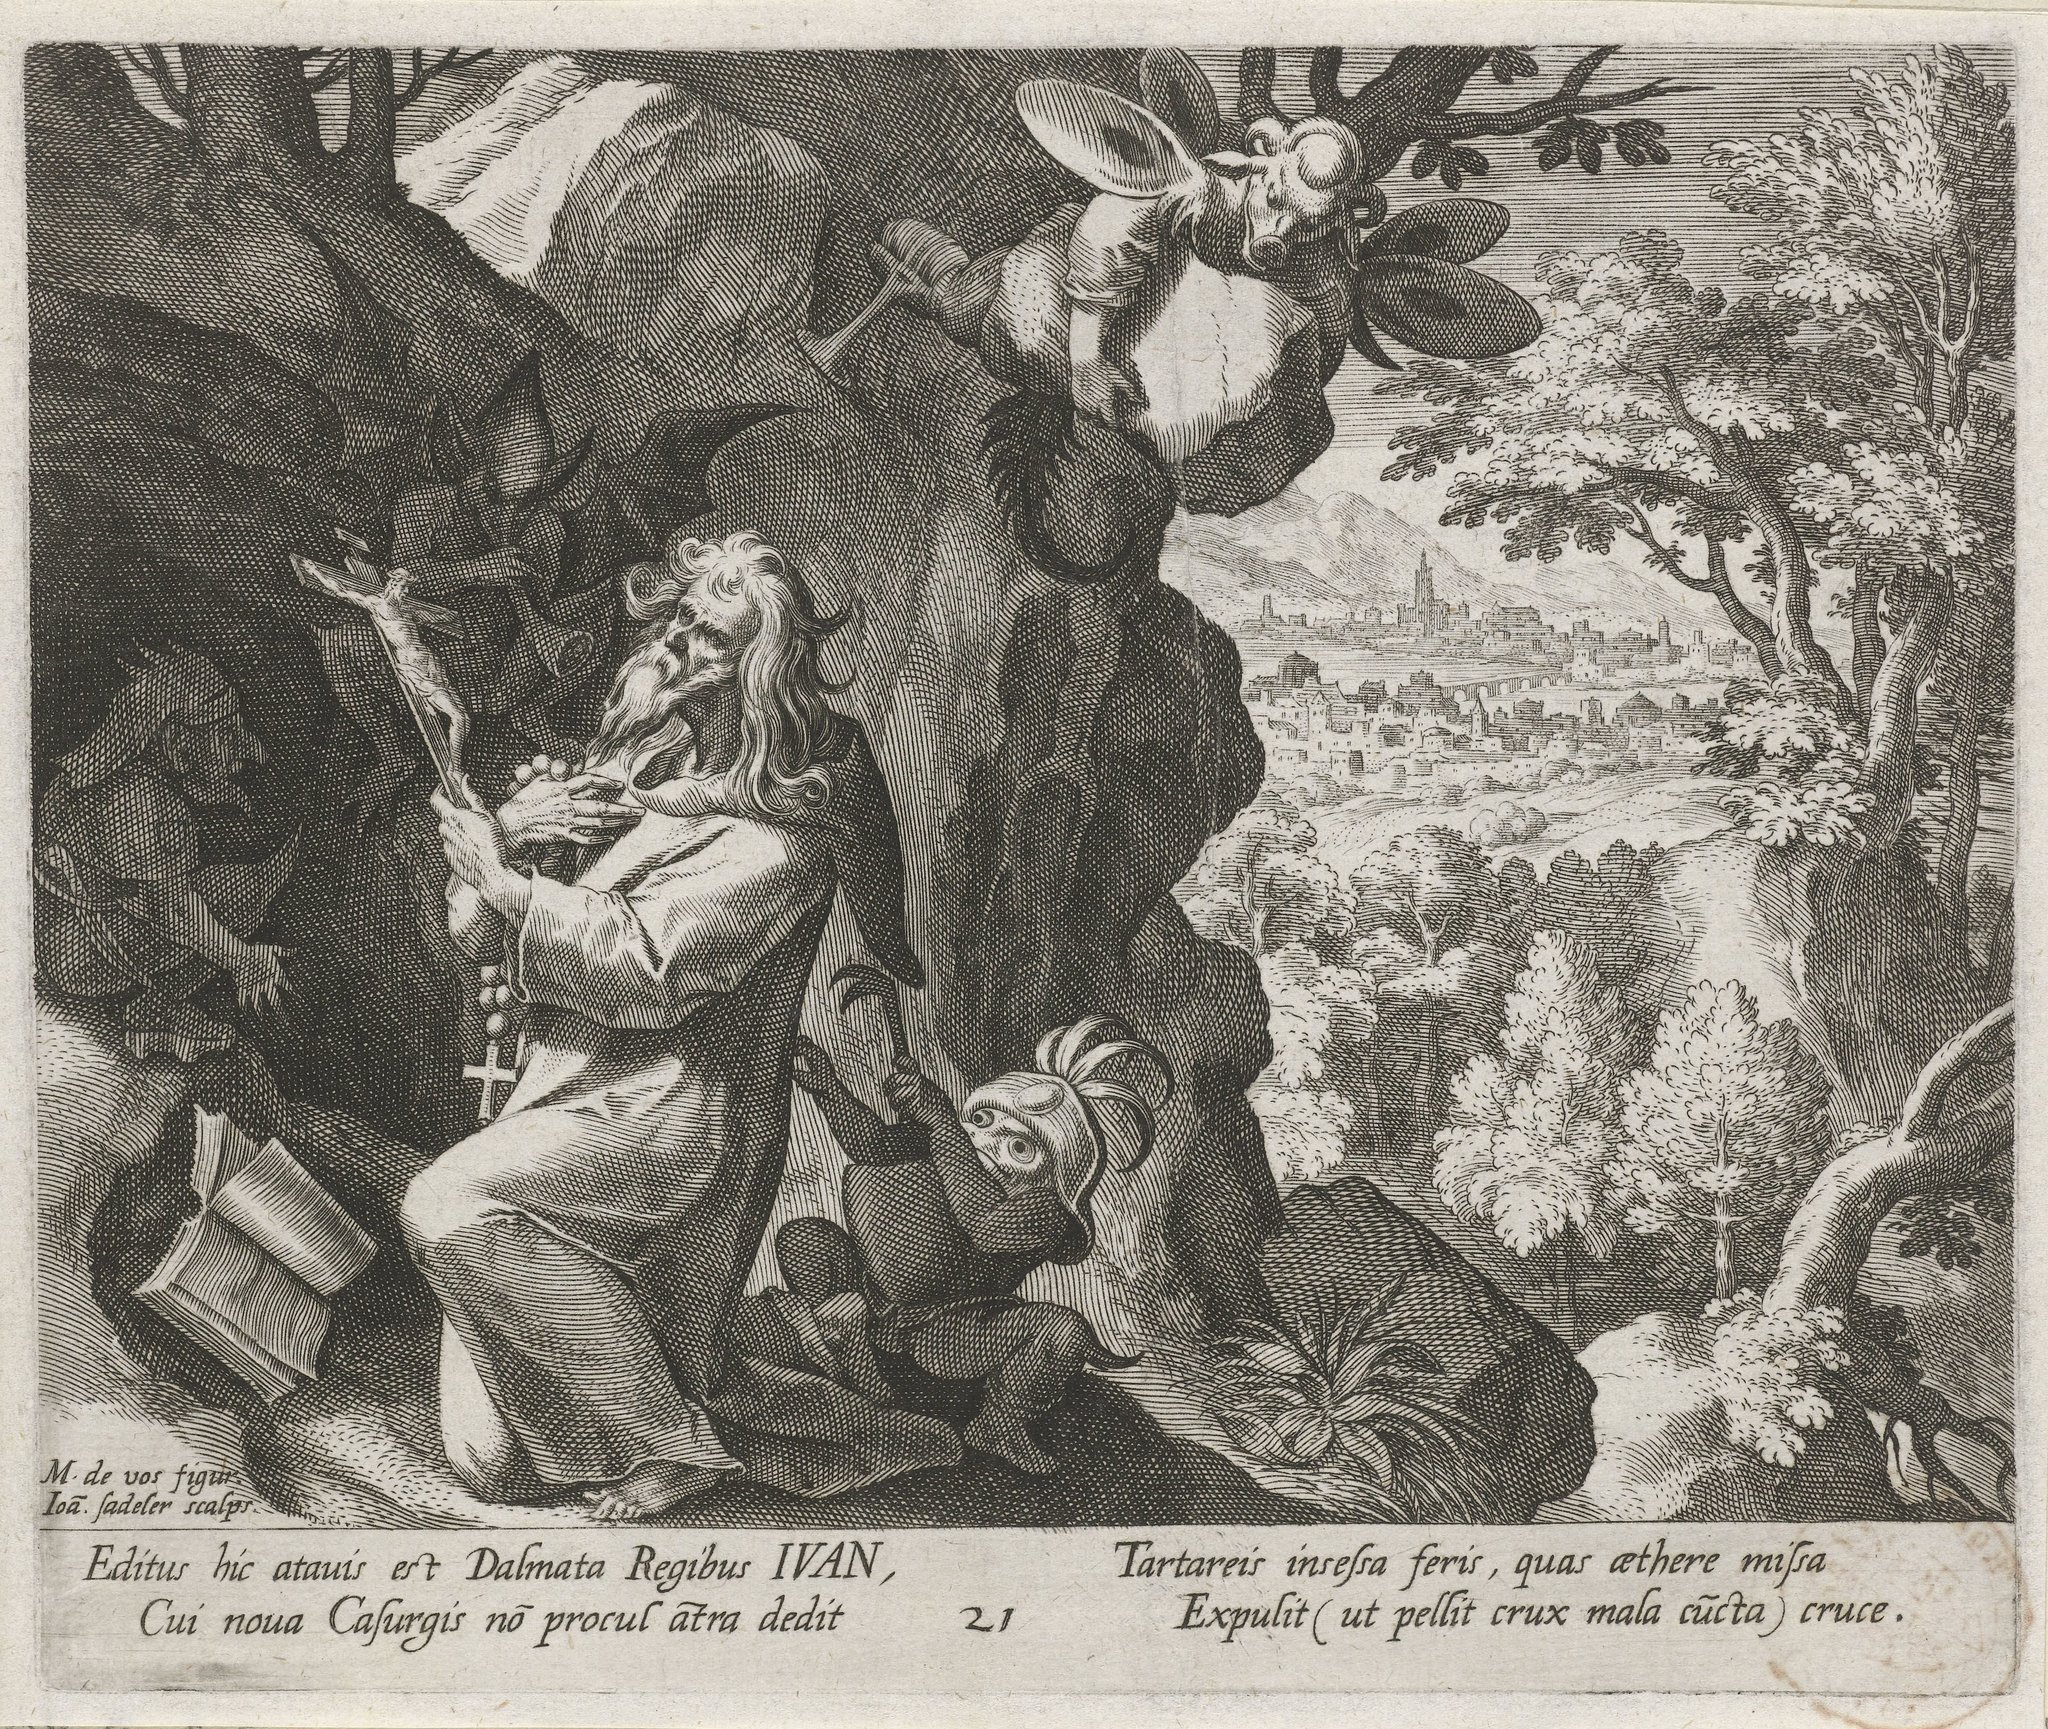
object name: print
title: Mannelijke kluizenaars en heremieten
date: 1594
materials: paper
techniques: engraving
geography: munich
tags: devils in purely fantasy shape, male saints (with name), anchorite, hermit, cave, grotto, mountains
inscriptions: collector's mark: Lugt 240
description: De H. Johannes (Ivan) van Bohemen, een kluizenaar uit de negende eeuw na Christus, voor een grot in een bergachtig landschap. Hij wordt belaagd door talrijke demonen. De kluizenaar bidt geknield voor een crucifix